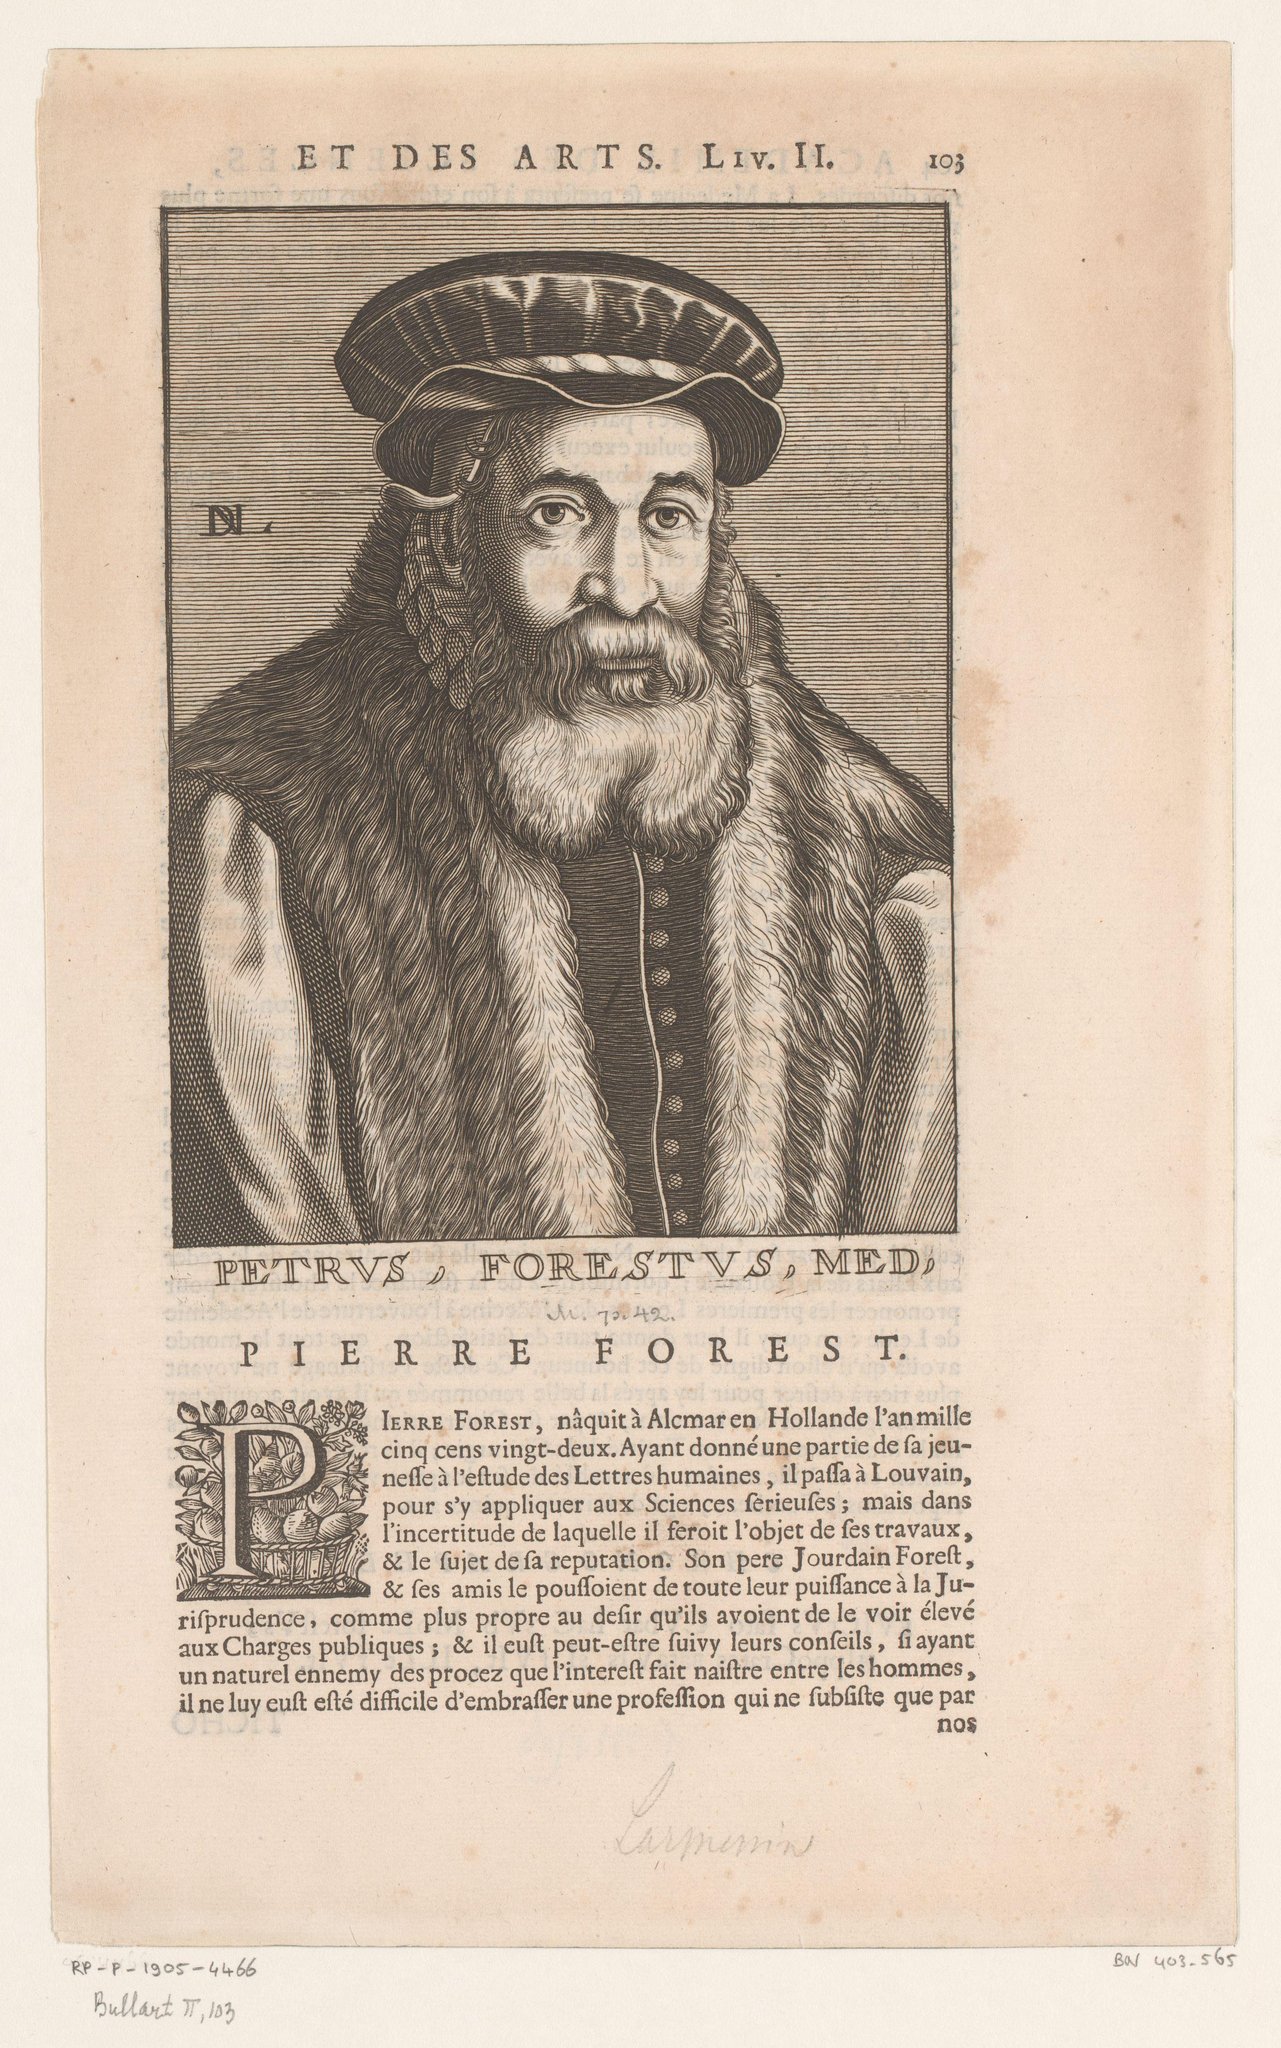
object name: book illustration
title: Portret van Pieter van Foreest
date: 1682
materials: paper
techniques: engraving, letterpress printing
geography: brussels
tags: historical persons, physician, doctor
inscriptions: collector's mark: Lugt 2228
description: Prent gebruikt voor: Bullart, Isaac. Académie des Sciences et Arts contenant les vies et éloges his. des hommes illustres qui ont excellé en ces professions depuis environ quatre siècles. Brussel: François Foppens, 1682. Het boek werd in 1682 eveneens in Amsterdam uitgegeven door de erfgenamen van Daniel Elzevier. Ieder portret betreft een illustratie bij de biografie van een kunstenaar of geleerde. De meeste portretten werden door Nicolas de Larmessin vervaardigd (162), 93 door De Boulonois en een derde door ongeïdentificeerde prentmakers. Dit betreft een illustratie op p. 103, deel II.